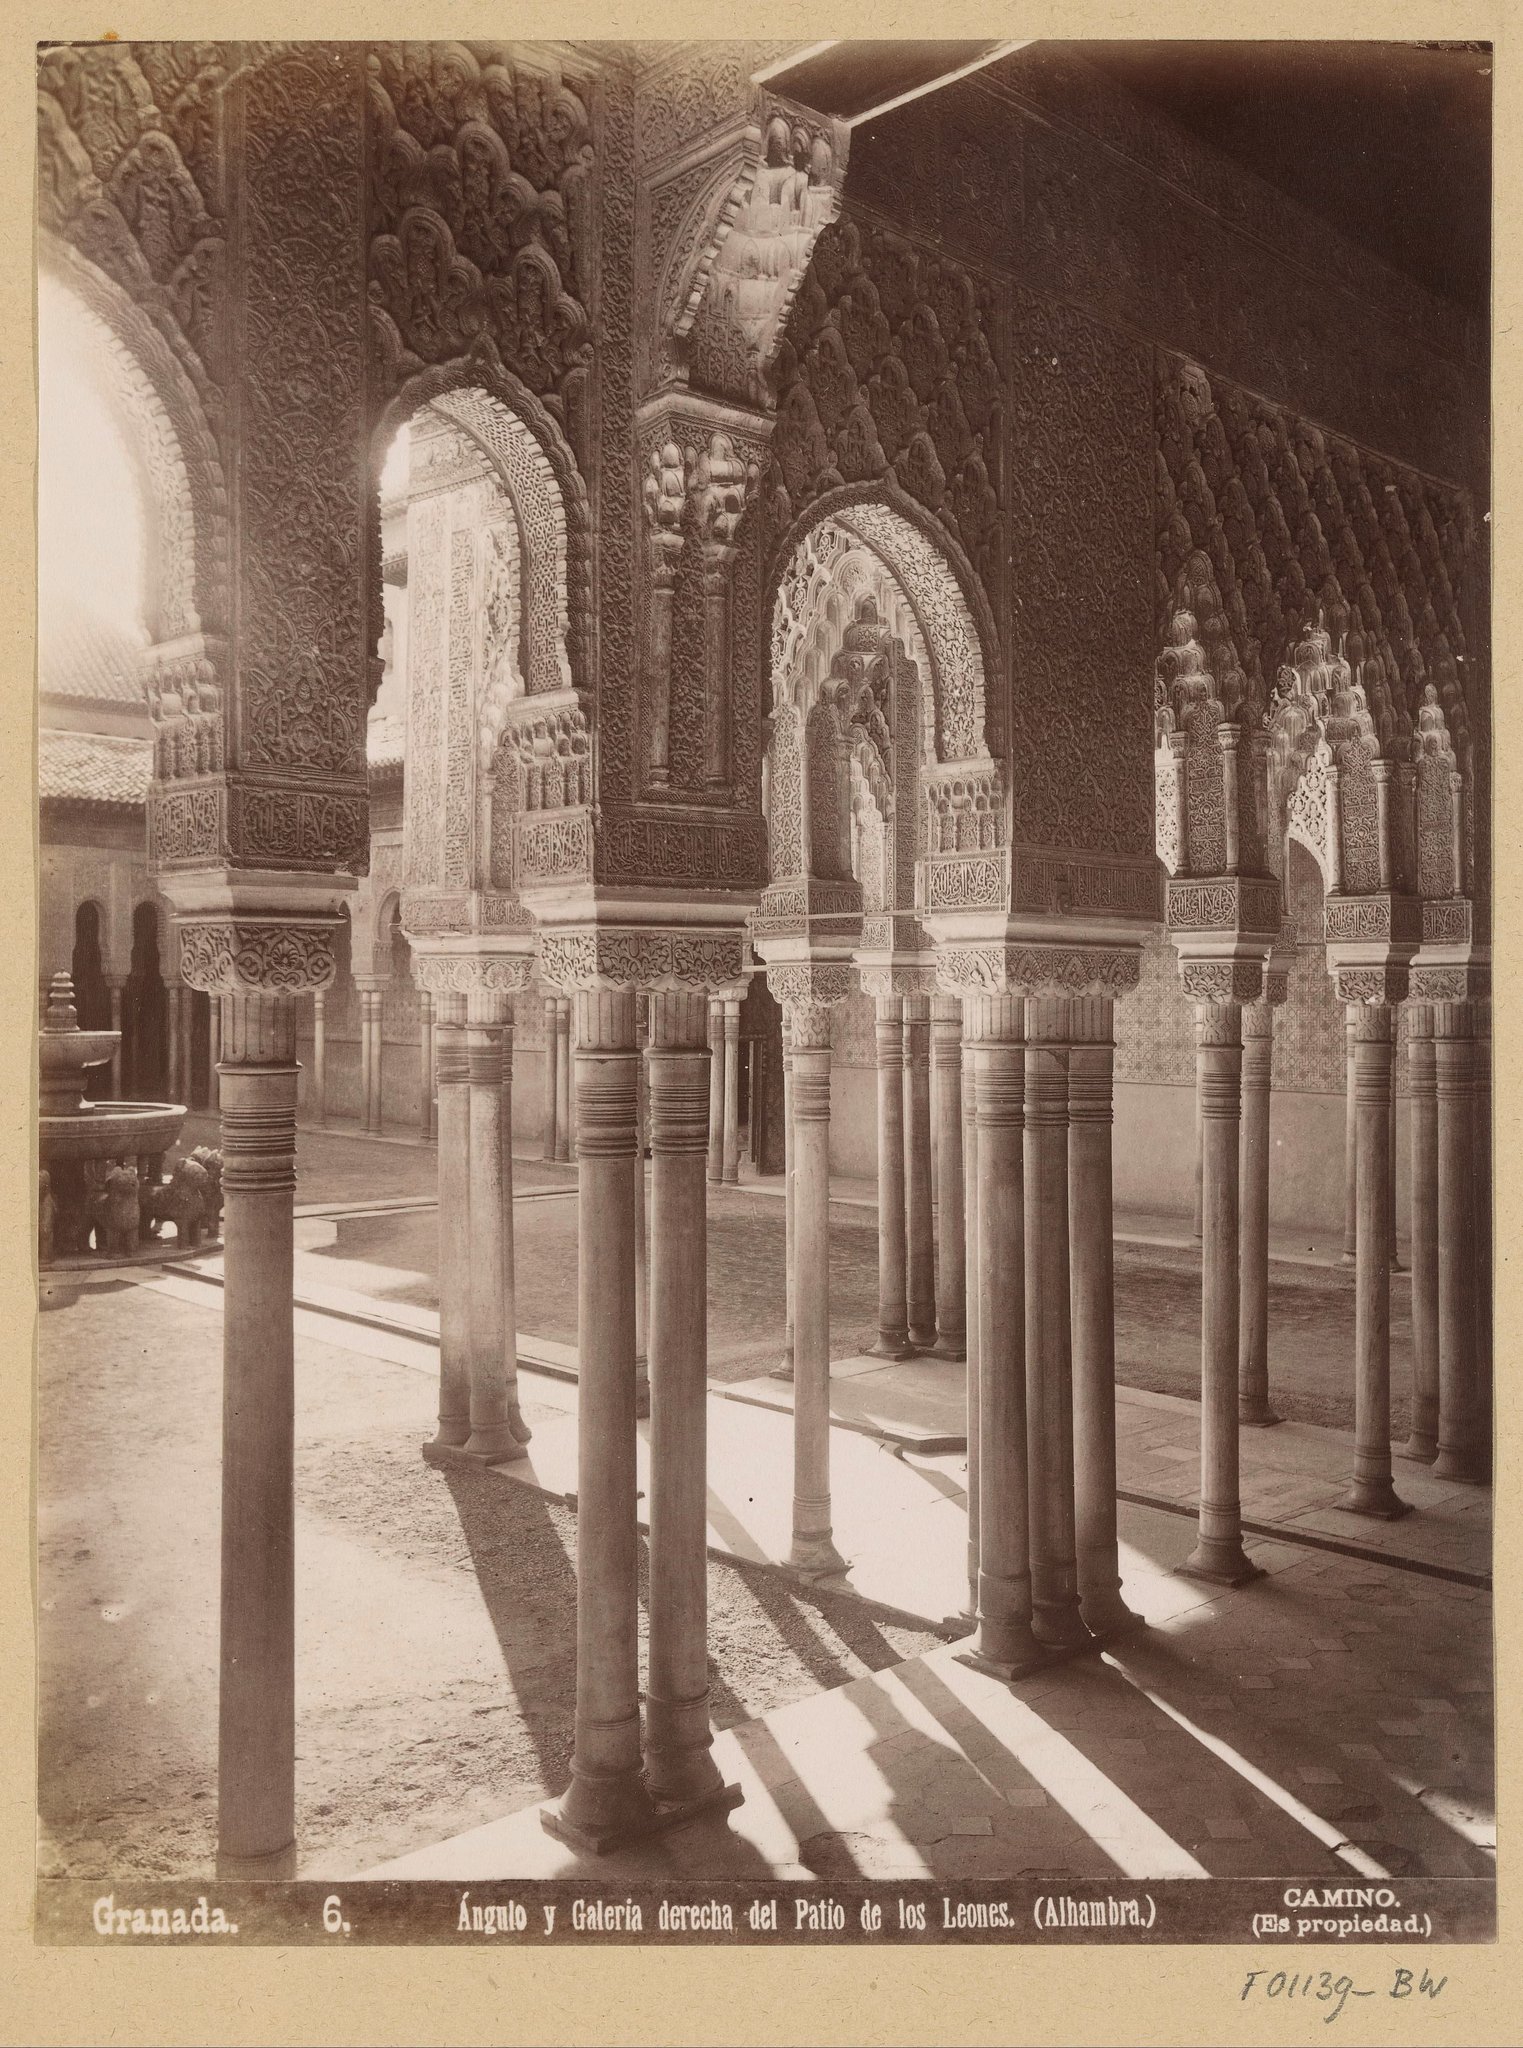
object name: photograph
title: Patio de los Leones in het Alhambra in Granada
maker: camino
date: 1851-1890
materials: paper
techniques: albumen print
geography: granada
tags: courtyard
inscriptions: inscription: ‘(Es propiedad.)’, number: ‘6.’